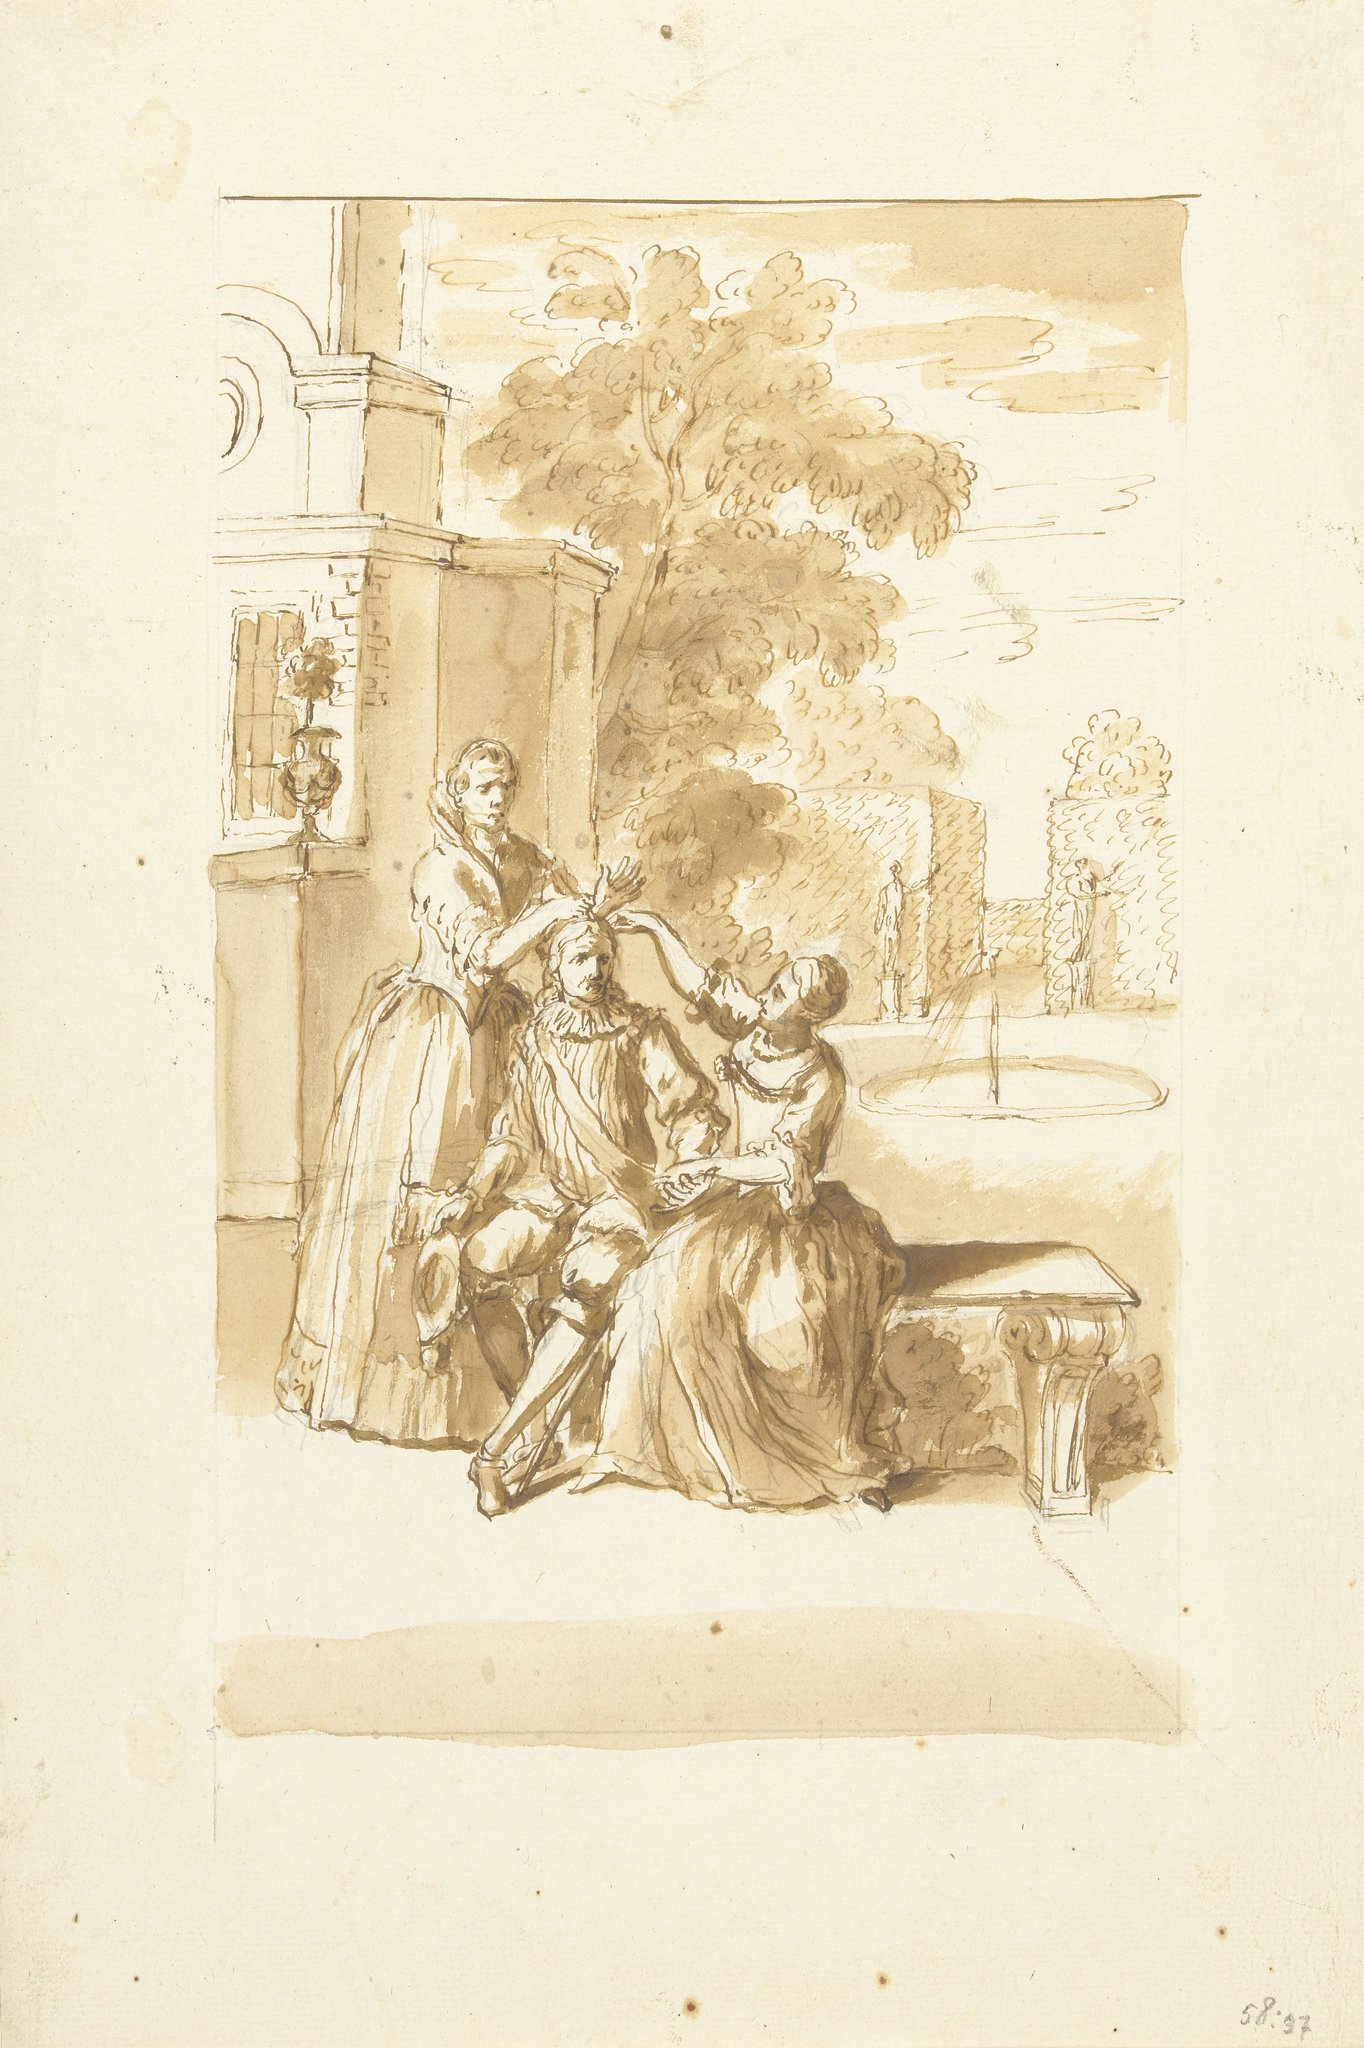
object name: drawing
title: Dichterkroning: twee dames bekransen een zittende man in een park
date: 1719-1790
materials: graphite, ink, paper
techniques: brush, pen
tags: rivalry of women for the love of a man; fight for the hose; 'andouille', lover crowned with a wreath, crowning with laurel, fame ~ writer, 'poeta laureatus'